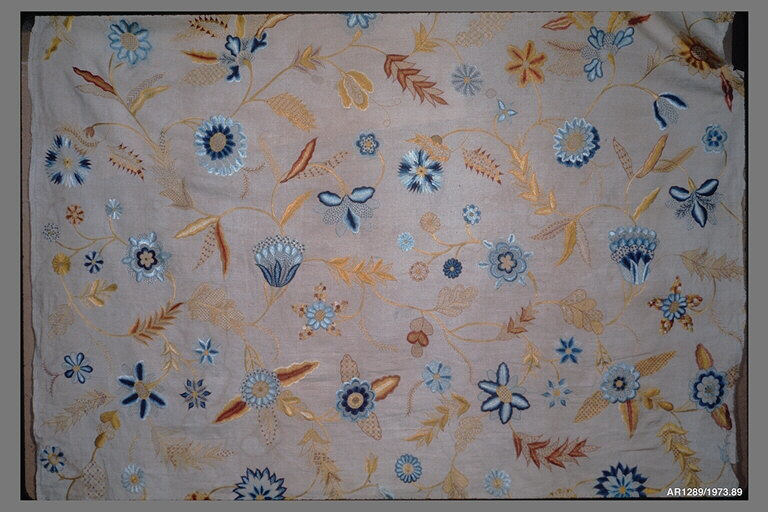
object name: piece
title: Skirt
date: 1701-1733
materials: linen, silk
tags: flowers